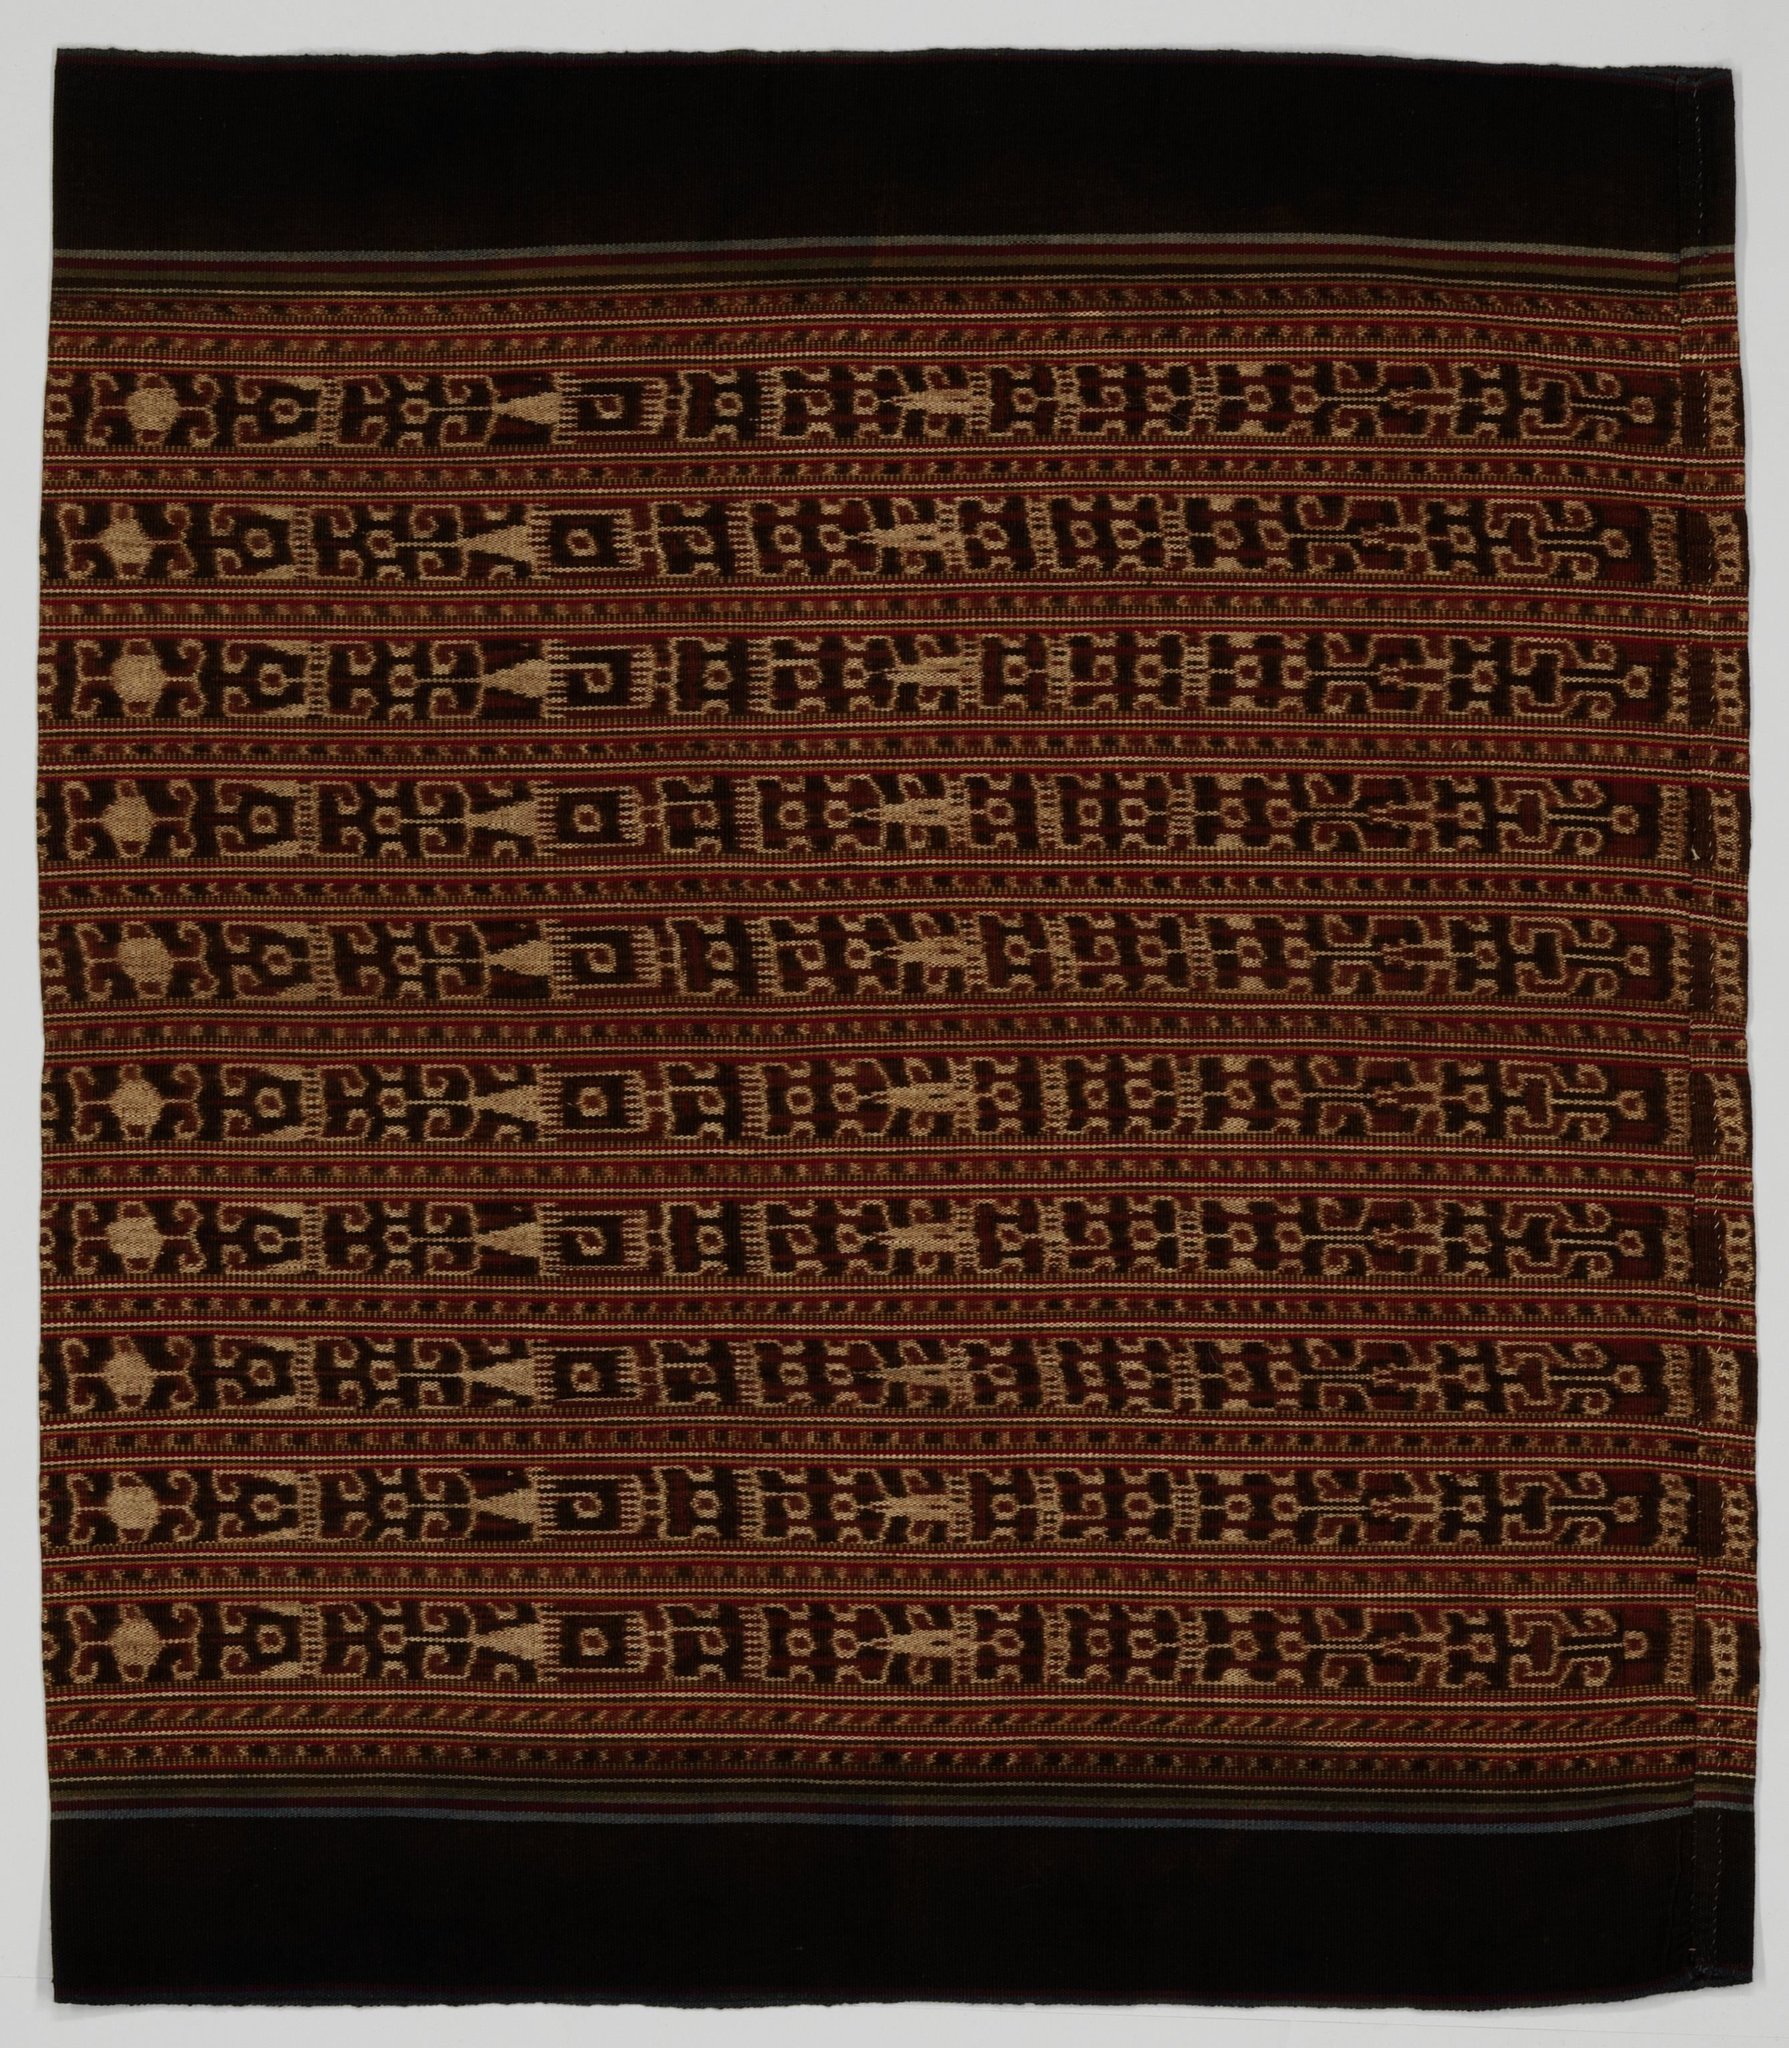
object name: cloth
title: Bidang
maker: Anonymous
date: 1950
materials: cotton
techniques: weave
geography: sarawak